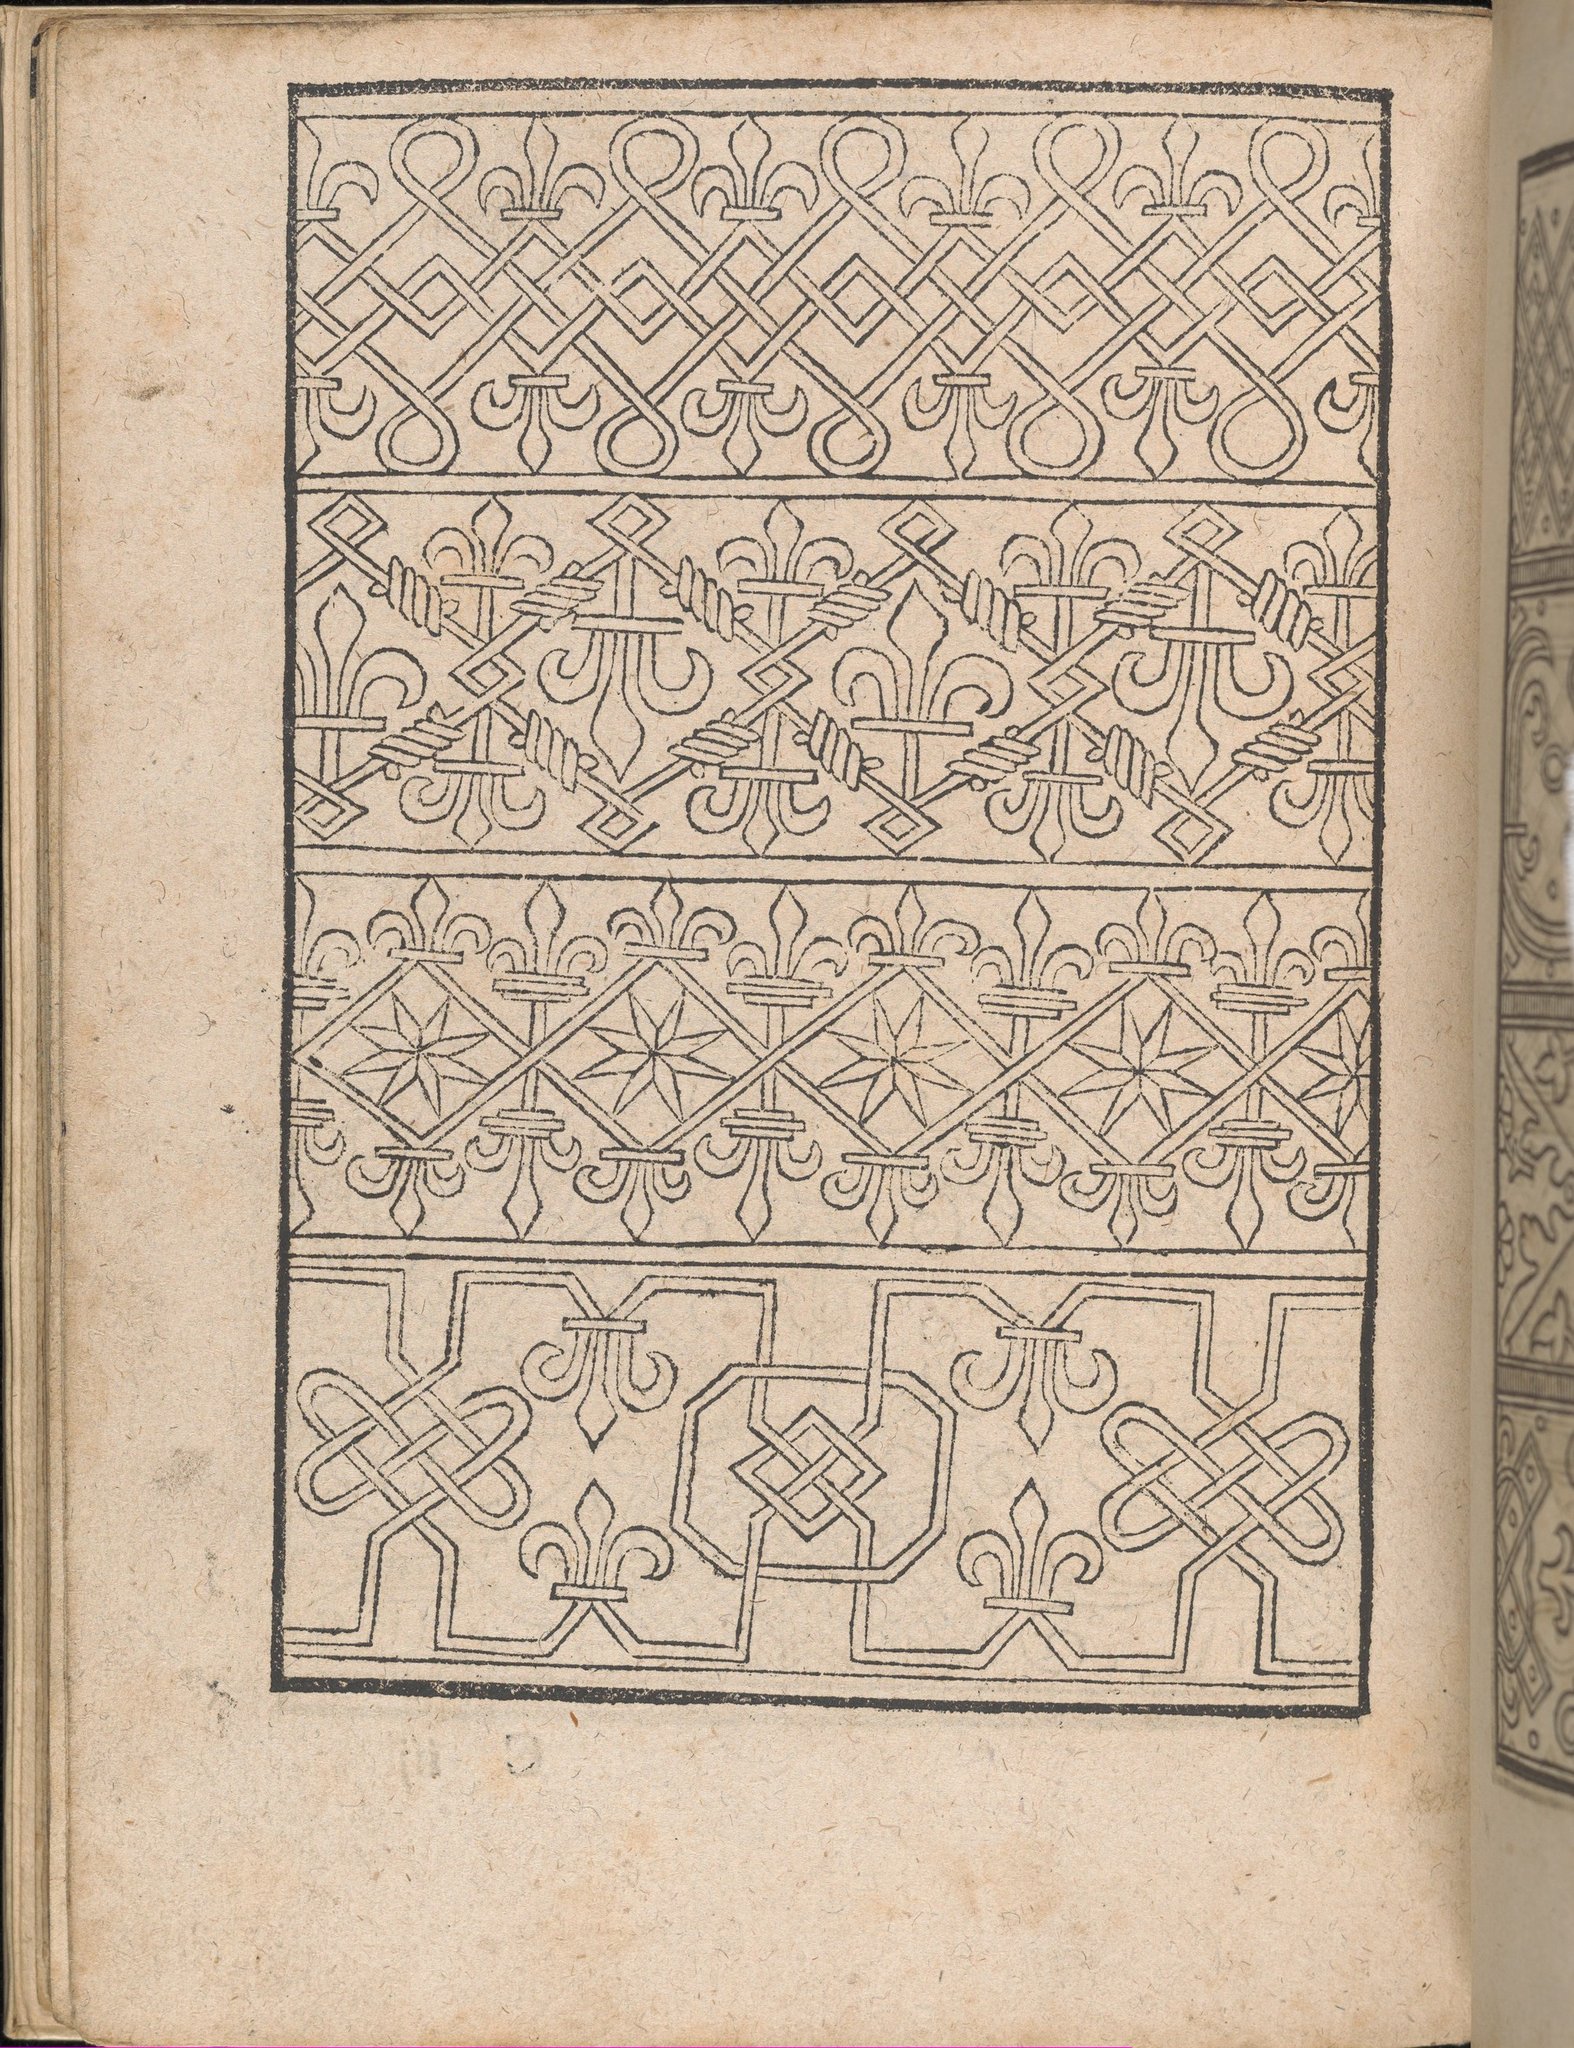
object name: book print ornament architecture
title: New Modelbüch allen Nägerin u. Sydenstickern (Page 11v)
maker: hans hoffman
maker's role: designer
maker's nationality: german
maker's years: 1556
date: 1556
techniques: woodcut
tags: ornament